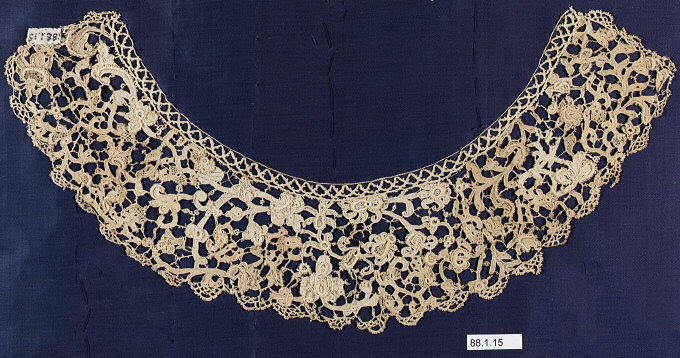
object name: collar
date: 1601-1633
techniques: lace